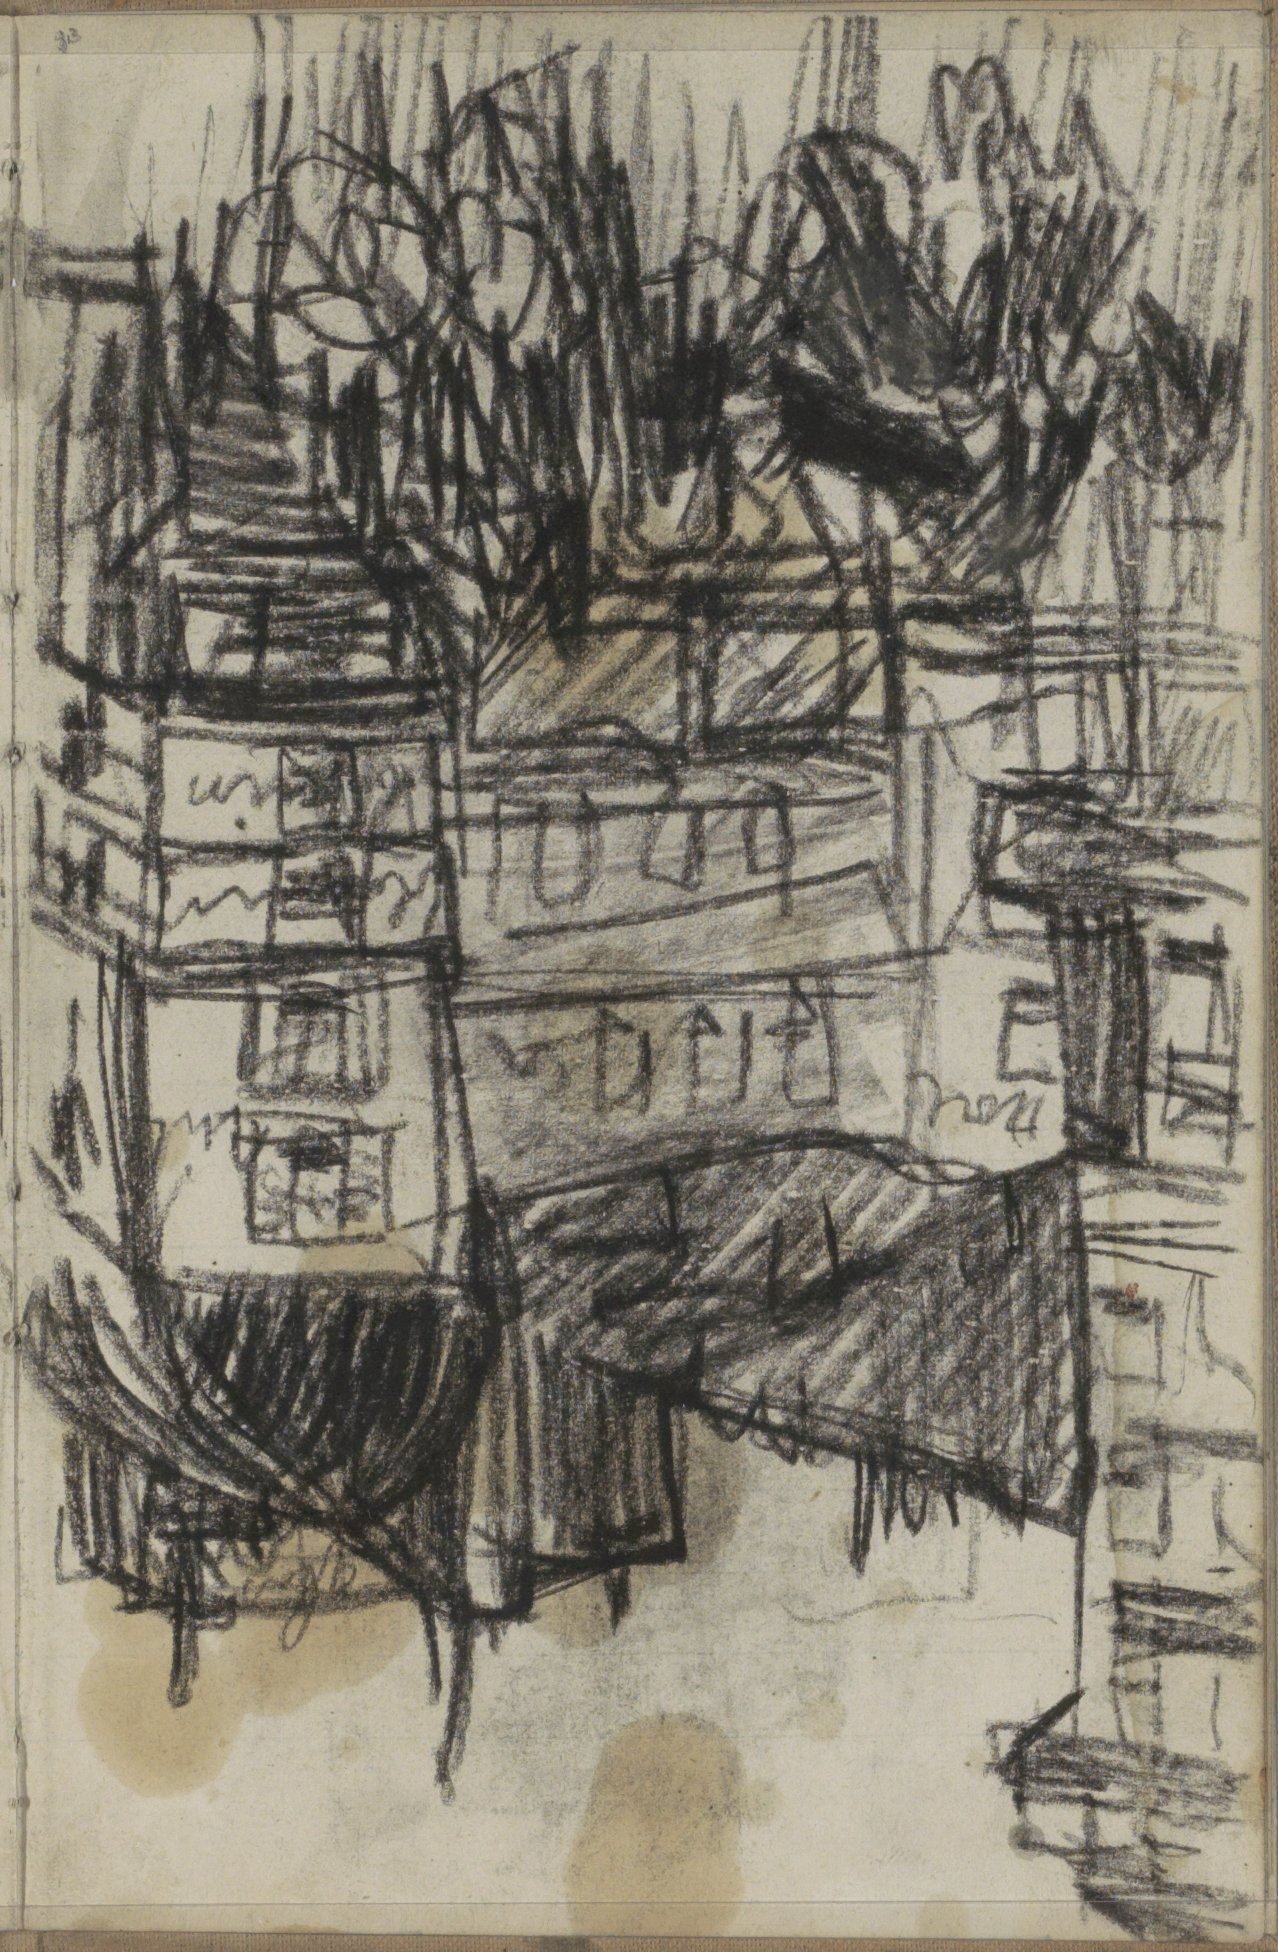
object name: sketchbook leaf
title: Straatgezicht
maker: marius bauer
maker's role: draughtsman, print maker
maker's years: 1867-1932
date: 1888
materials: chalk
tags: architecture, street (+ city(-scape) with figures, staffage)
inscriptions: kleurnotitie, handgeschreven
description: Pagina 93 uit een schetsboek met 49 bladen.